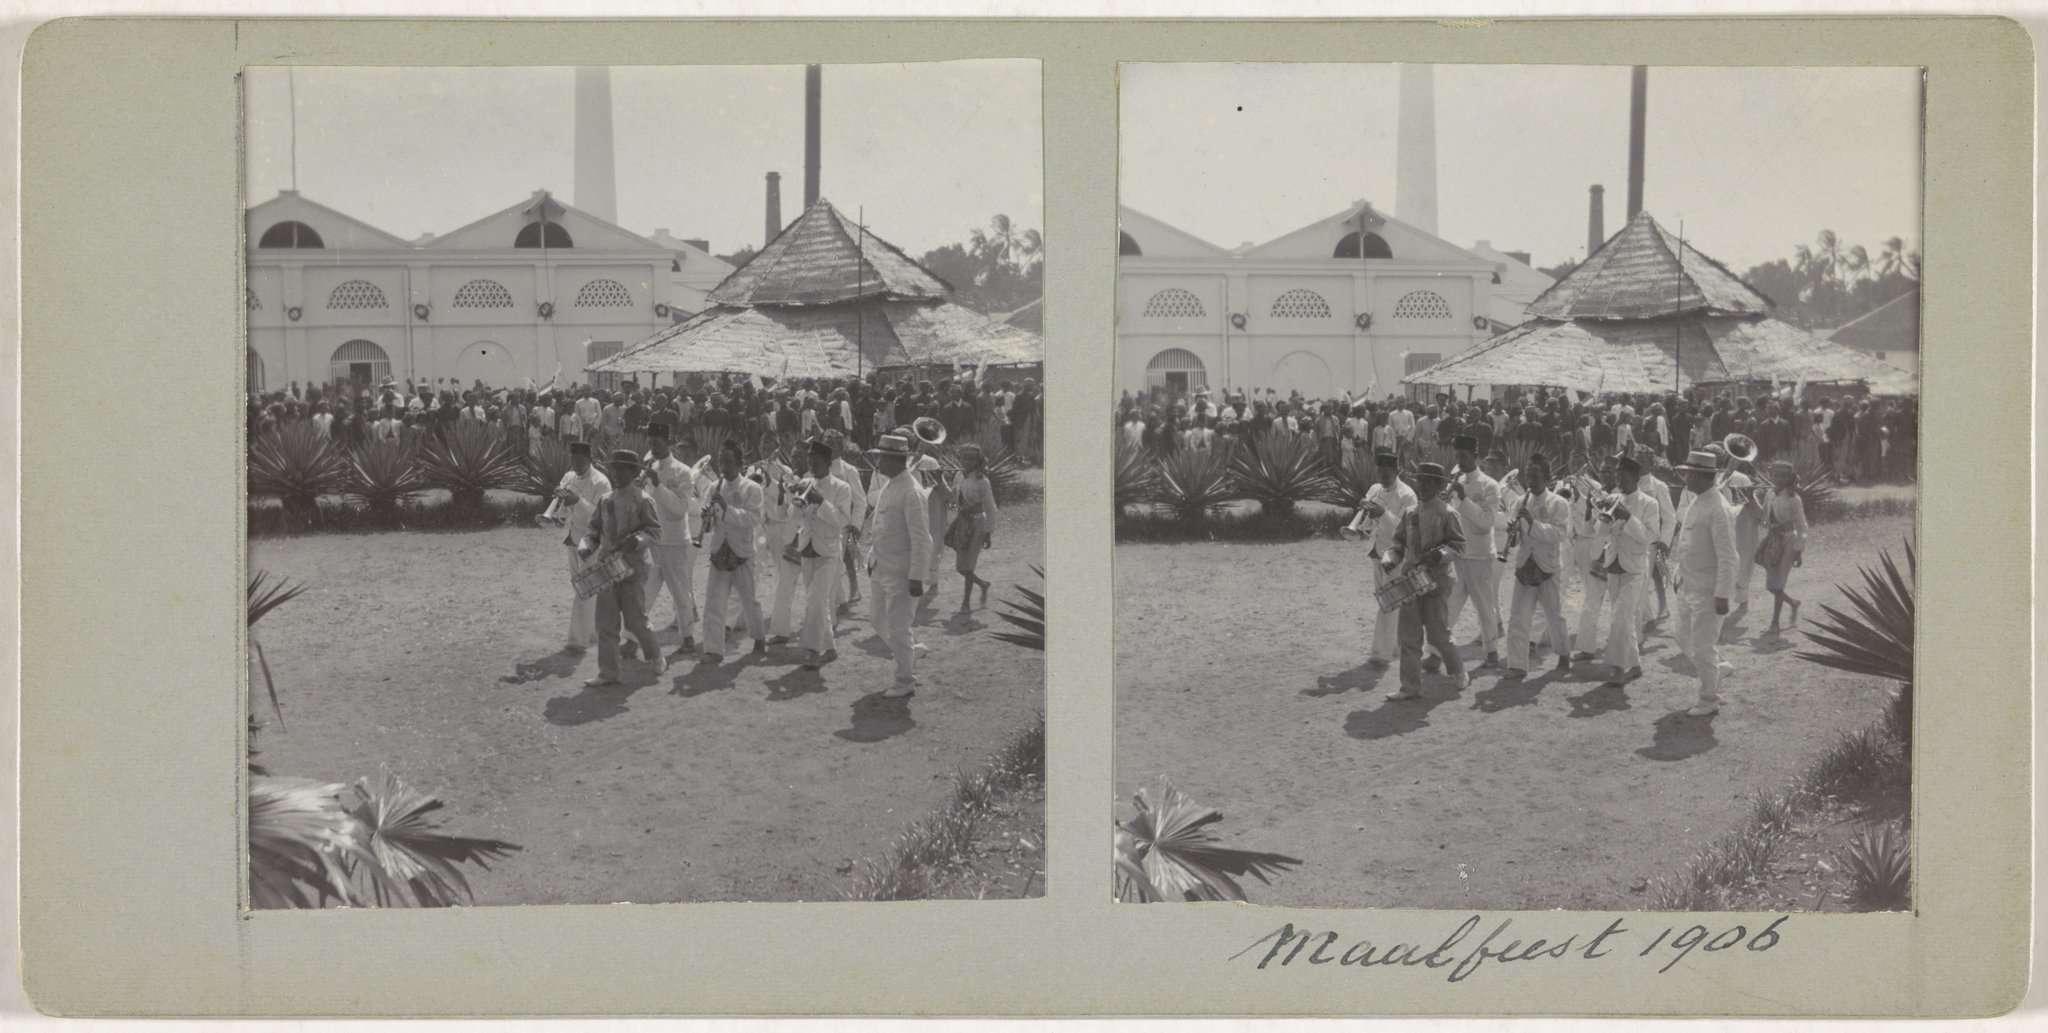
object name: stereograph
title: Groep mannen spelend op instrumenten tijdens het Maalfeest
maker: Anonymous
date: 1906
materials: cardboard, paper, photographic support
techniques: albumen print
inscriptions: title: ‘Maalfeest 1906’